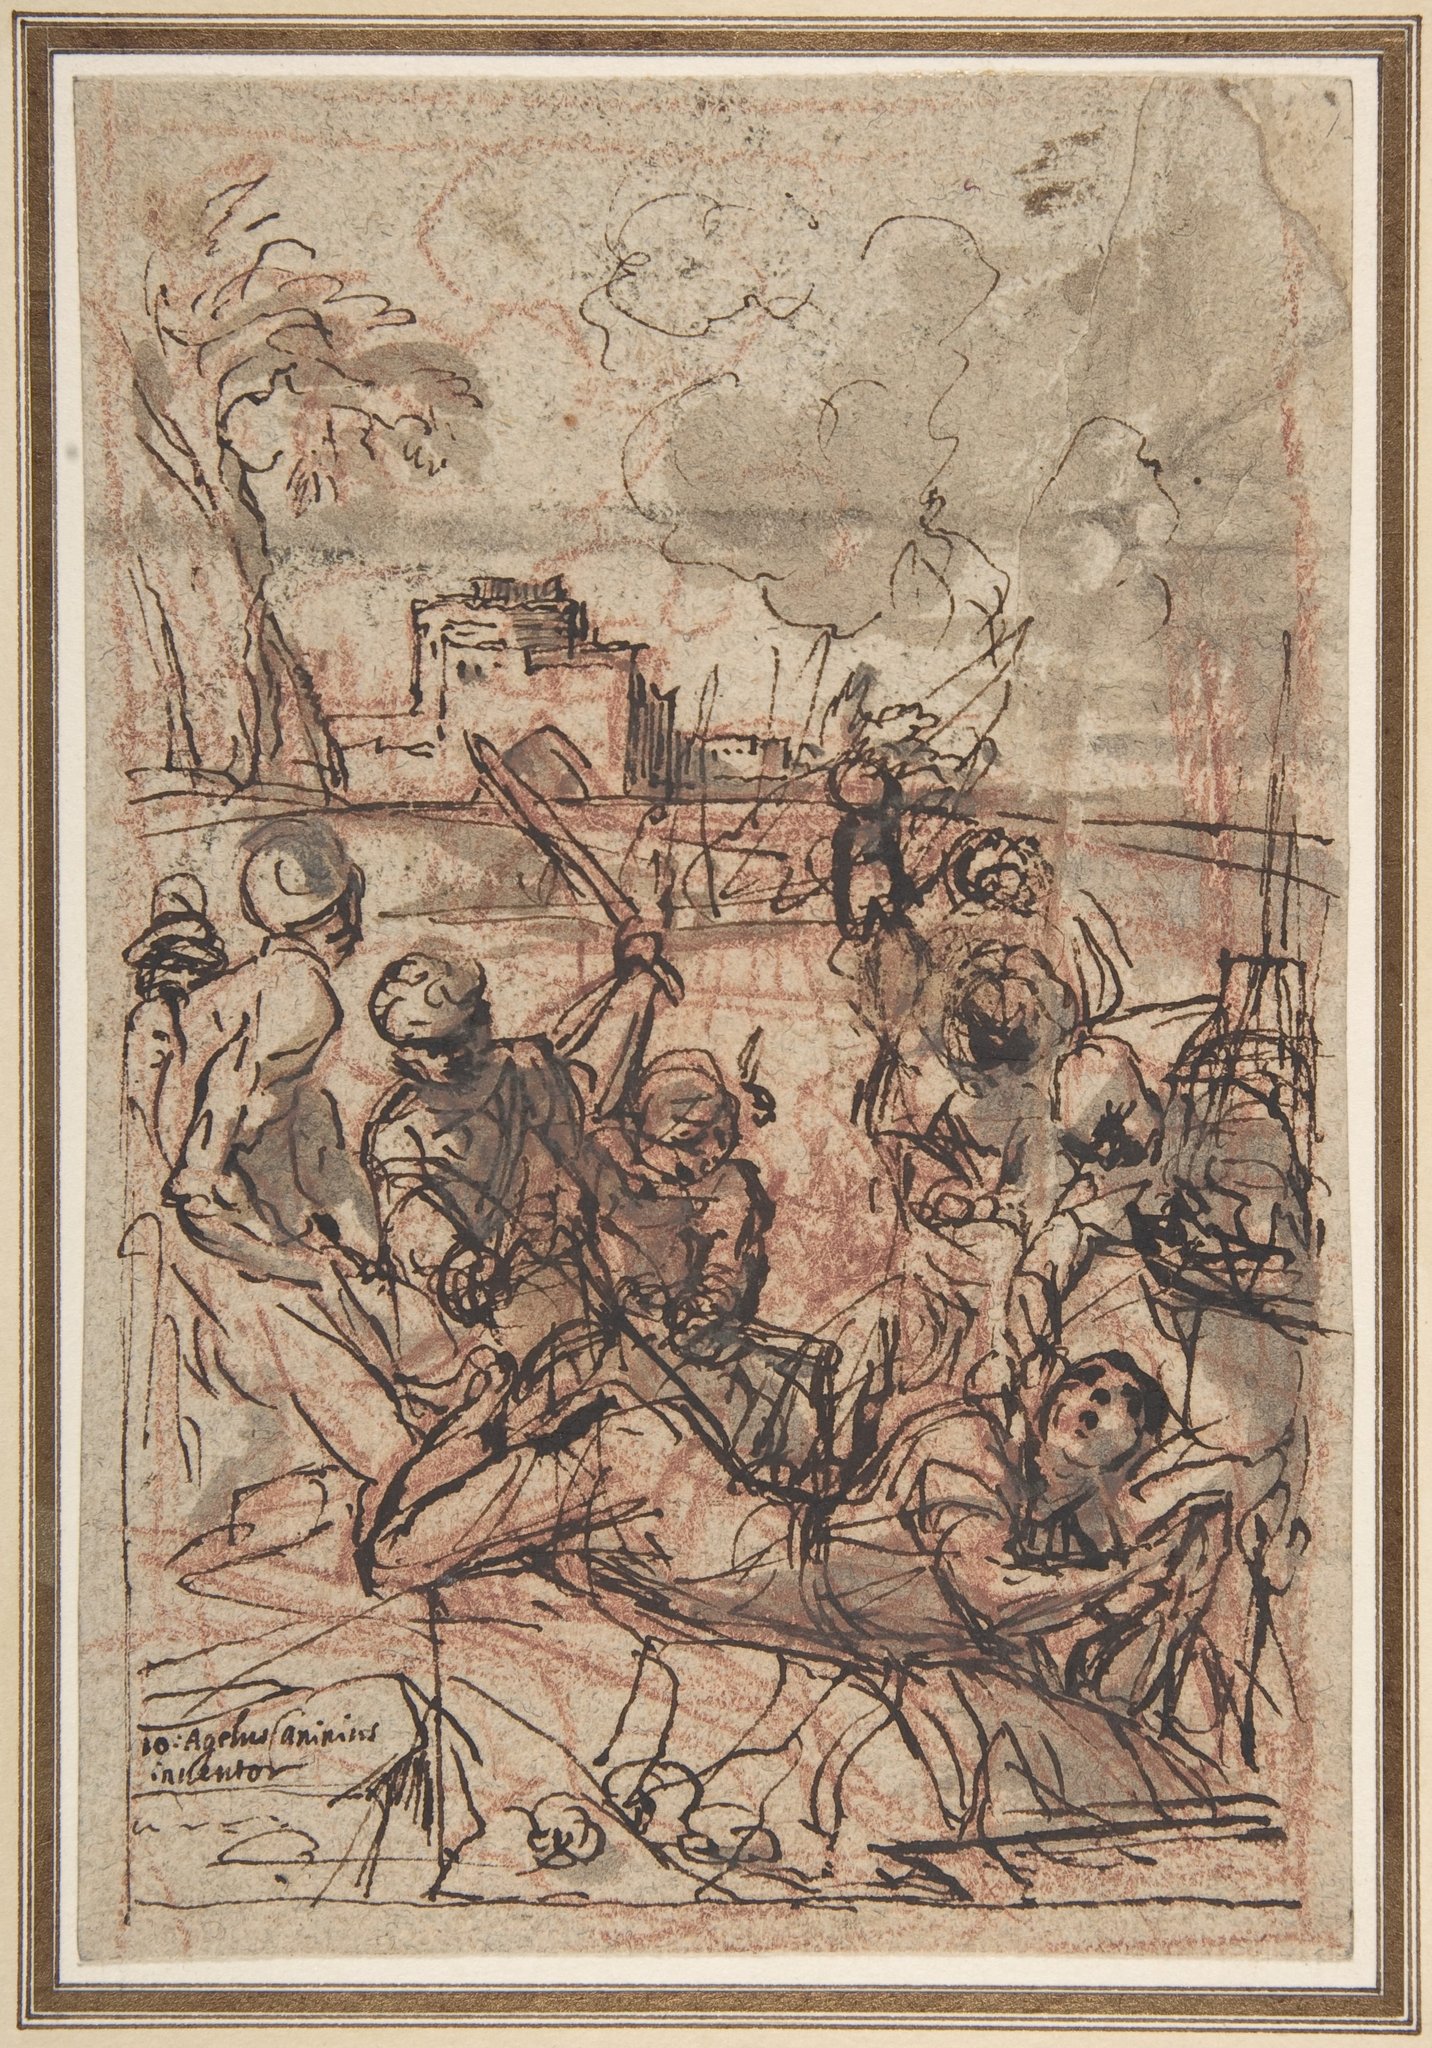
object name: drawing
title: Scene of Martyrdom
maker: giovanni angelo canini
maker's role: artist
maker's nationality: italian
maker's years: 1609-1666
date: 1615-1666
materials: chalk, ink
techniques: brush, pen, wash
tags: weapons,suffering,men